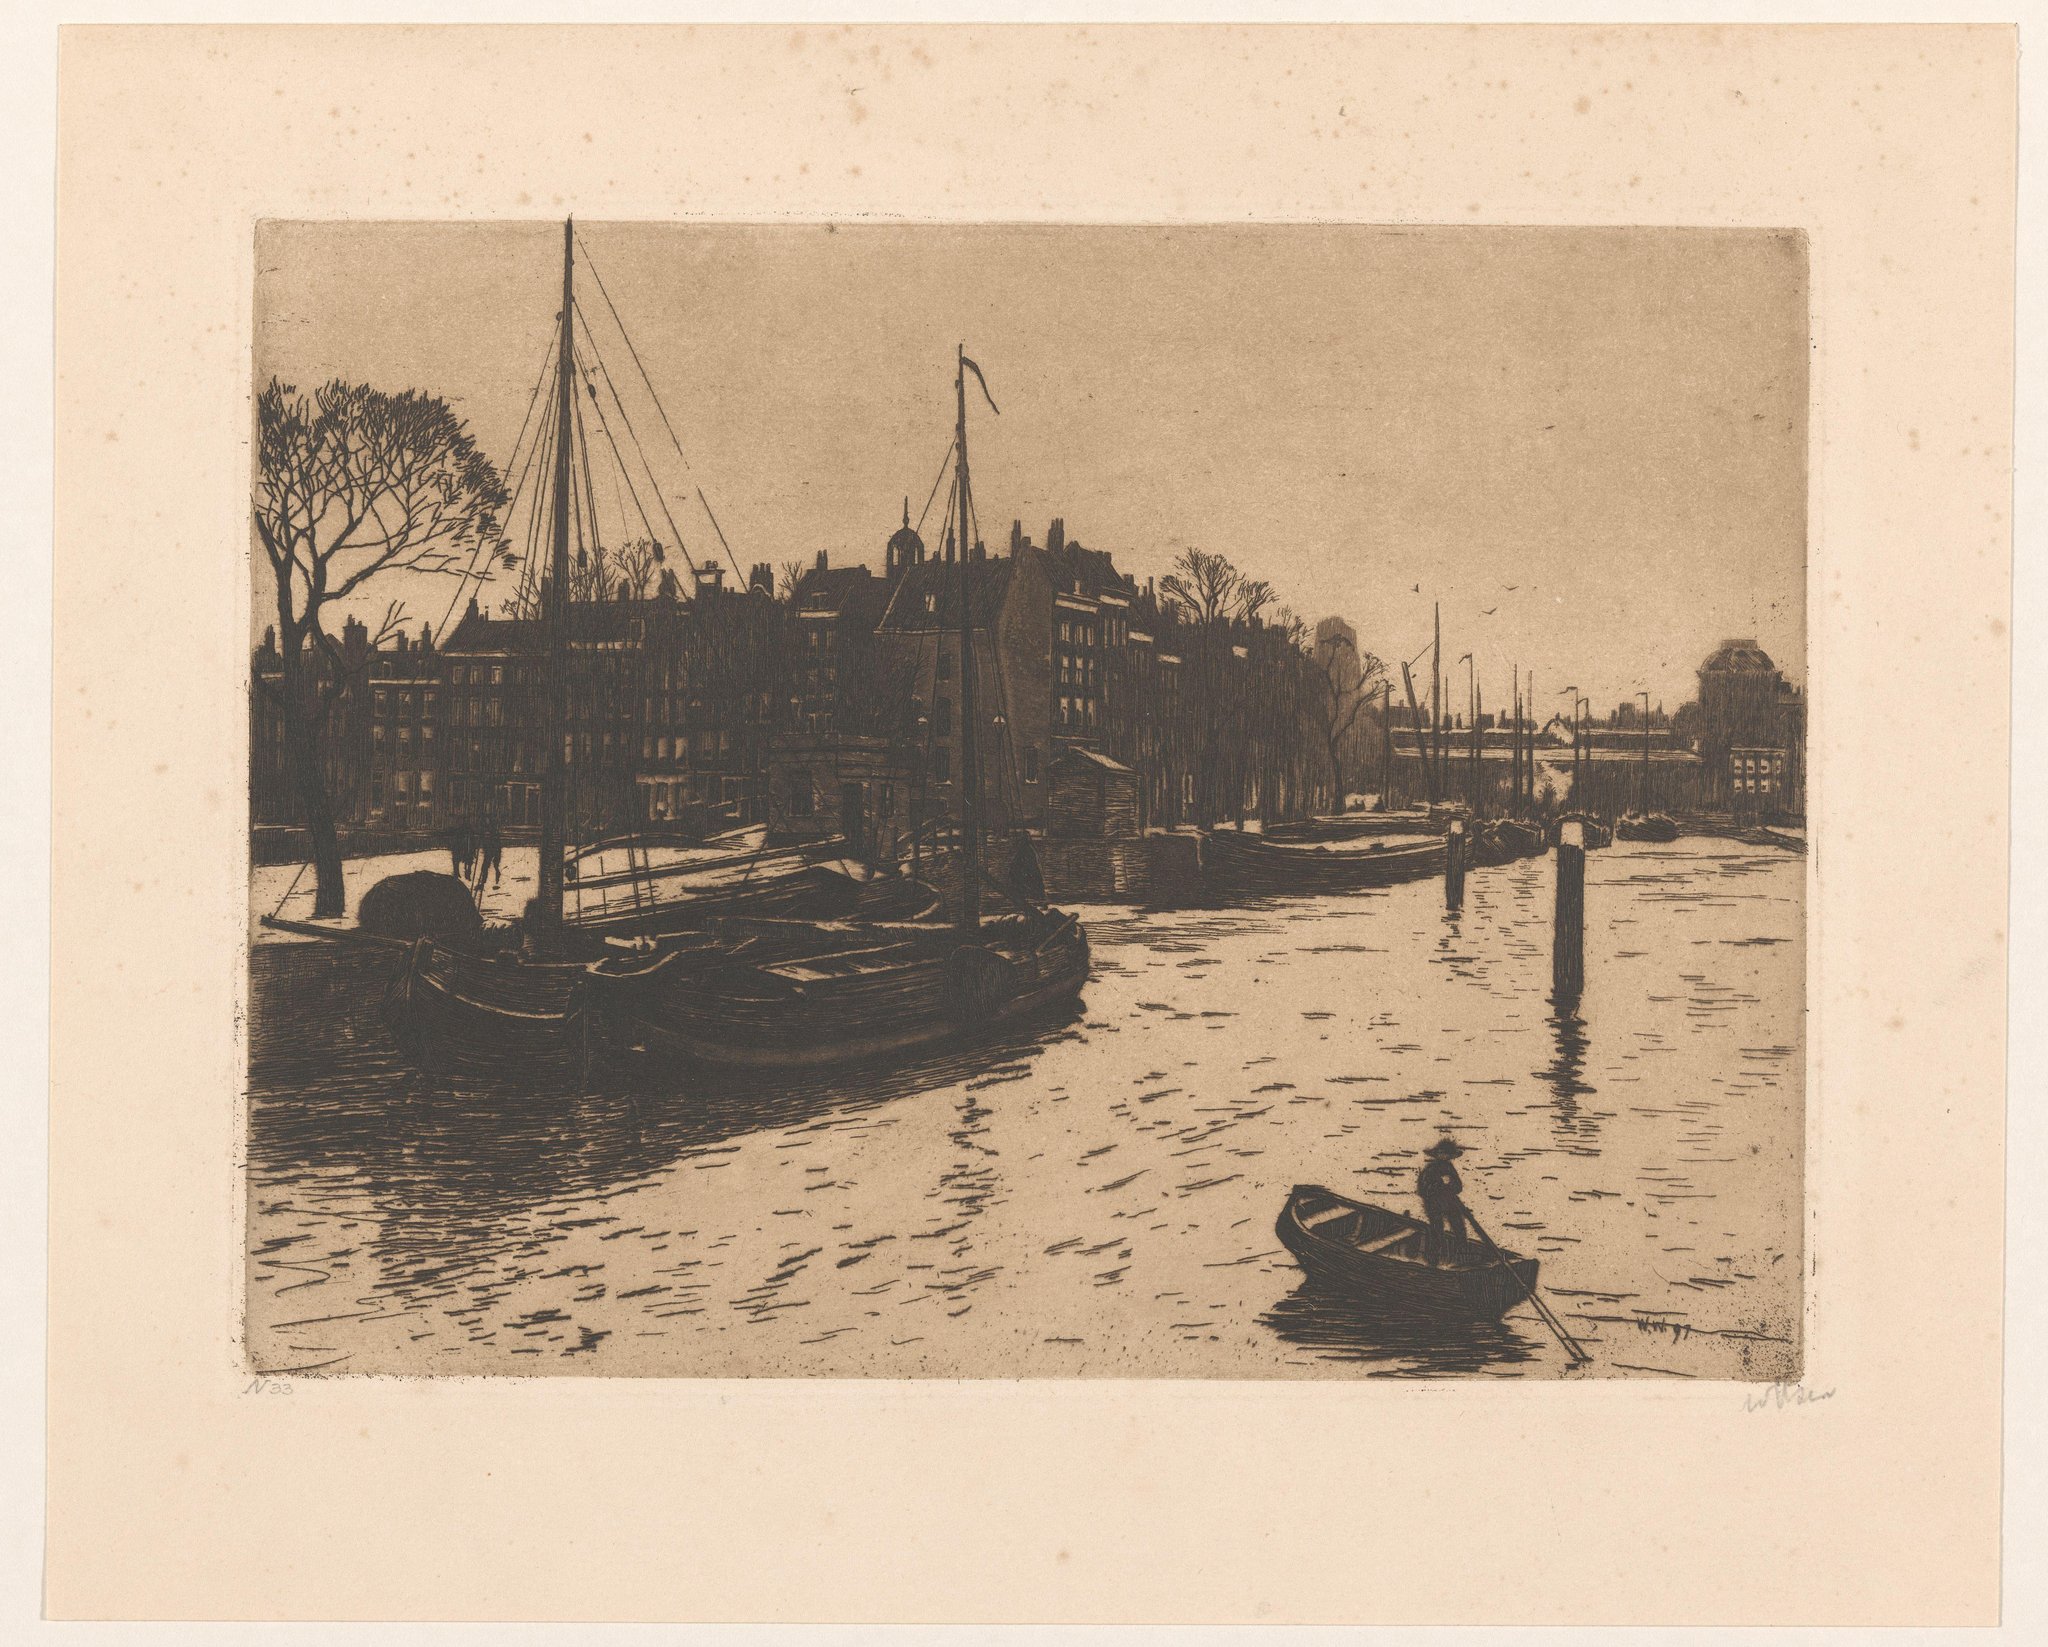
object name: print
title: Gezicht op de Leuvehaven in Rotterdam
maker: willem witsen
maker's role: draughtsman, painter, print maker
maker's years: 1860-1923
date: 1897-1906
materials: paper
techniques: aquatint, etching, intaglio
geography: amsterdam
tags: urban housing, canals, waters (in city), traffic on the water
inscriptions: watermark:, collector's mark: Lugt 2760, inscription: ‘N 33’, collector's mark: Lugt 2228